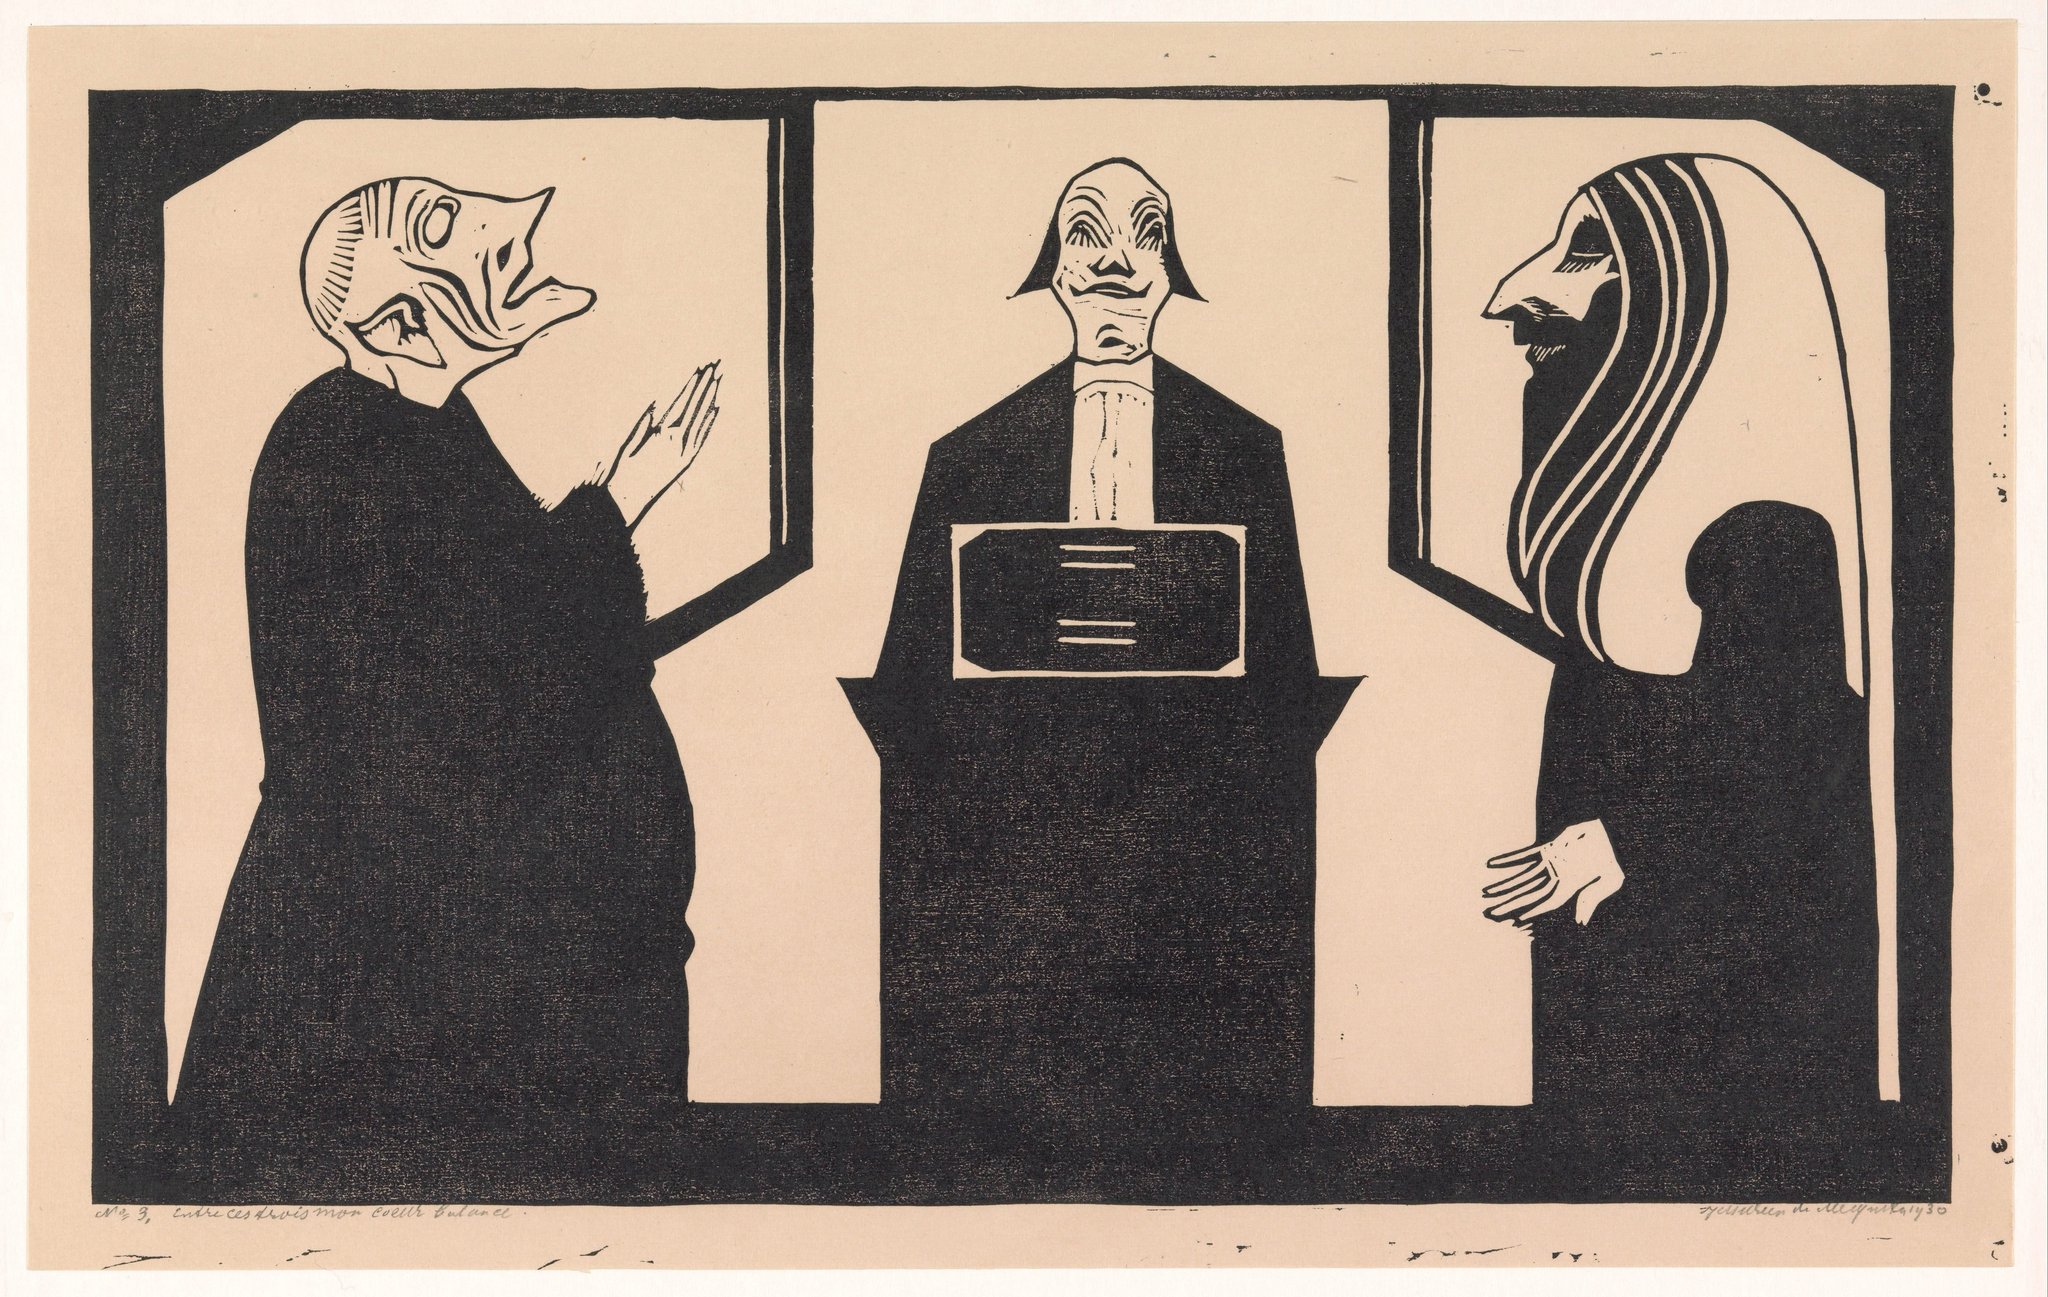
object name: print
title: Entre ces trois mon coeur balance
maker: samuel jessurun de mesquita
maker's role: draughtsman, print maker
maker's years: 1868-1944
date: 1930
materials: paper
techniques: woodcut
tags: head-gear: hood, old man, speaking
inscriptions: collector's mark: Lugt 2228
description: In het midden een man achter een lessenaar. Links een kale man die omhoog kijkt; rechts een man met een kap en gesloten ogen.